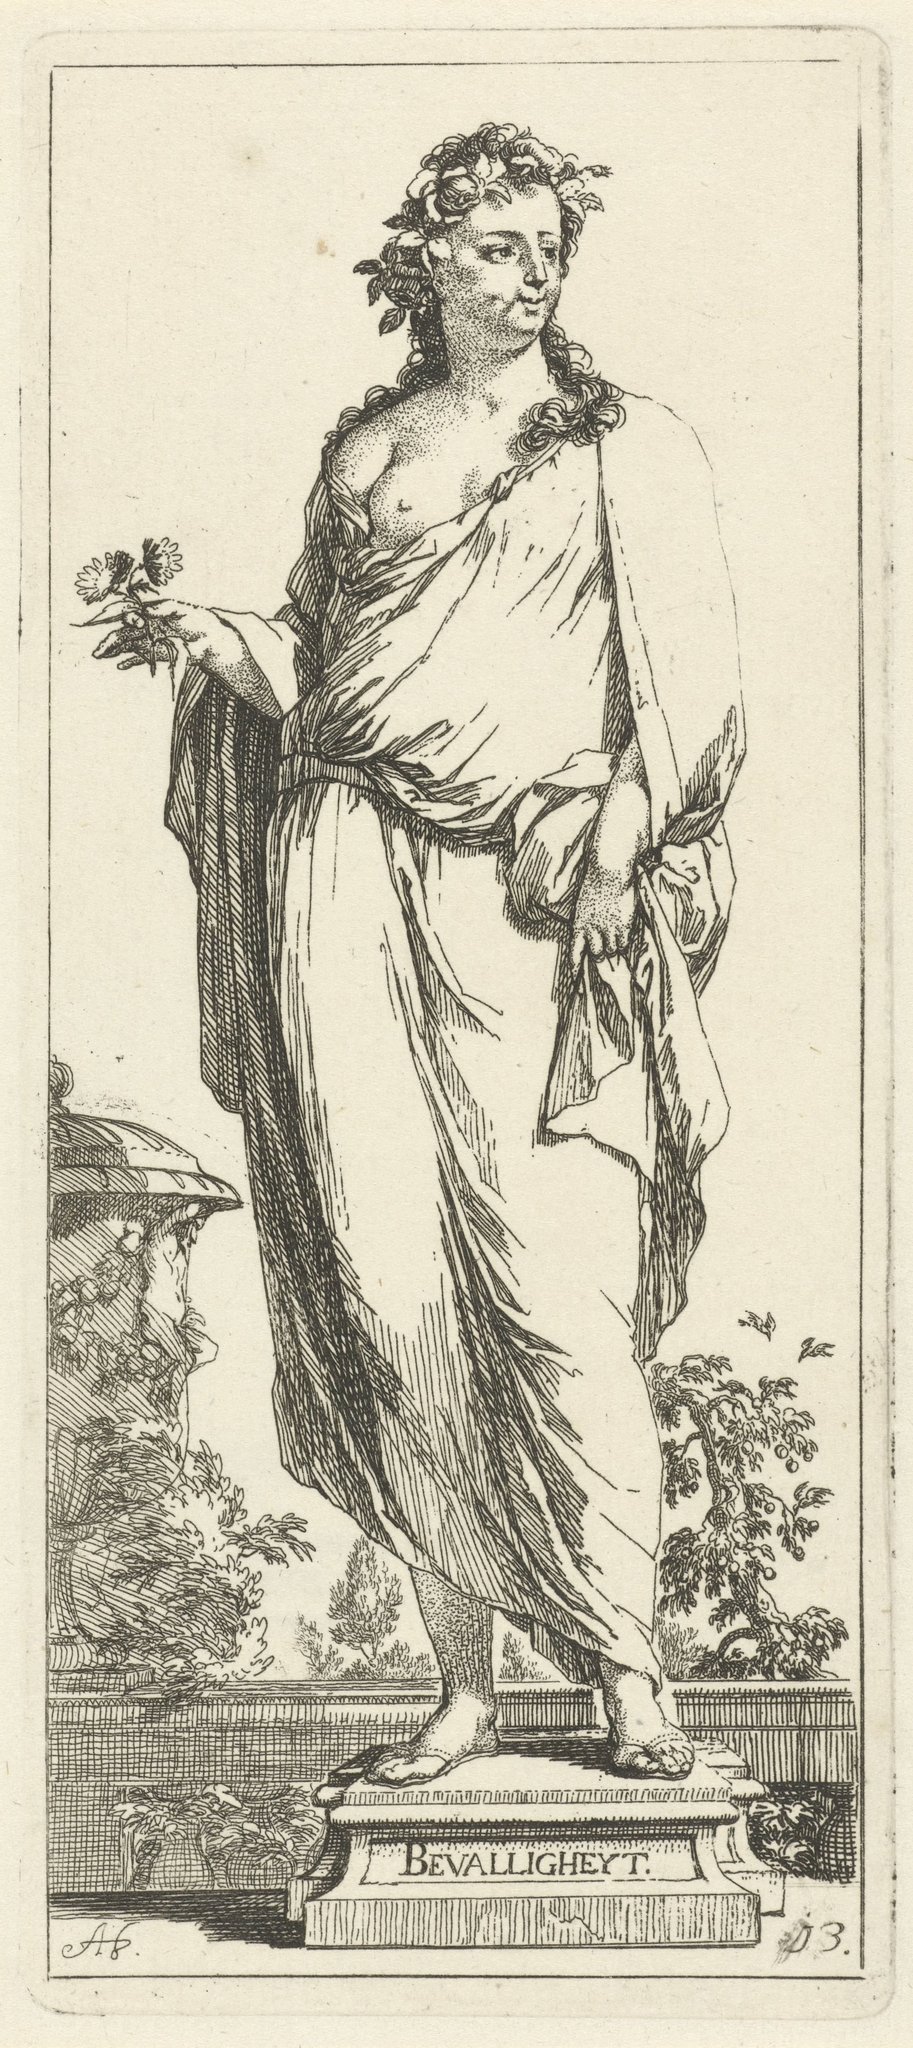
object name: print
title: Gepersonifieerde Bevalligheid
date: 1710-1719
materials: paper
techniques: etching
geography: amsterdam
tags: flowers, elegance (+ abstract concept represented by female figure)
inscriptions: collector's mark: Lugt 2228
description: Een vrouwfiguur op een sokkel met bloemen in haar hand als personificatie van bevalligheid. Prent uit een serie van 41 zinnebeelden.